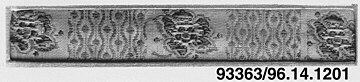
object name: piece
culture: japanese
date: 1701-1900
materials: silk